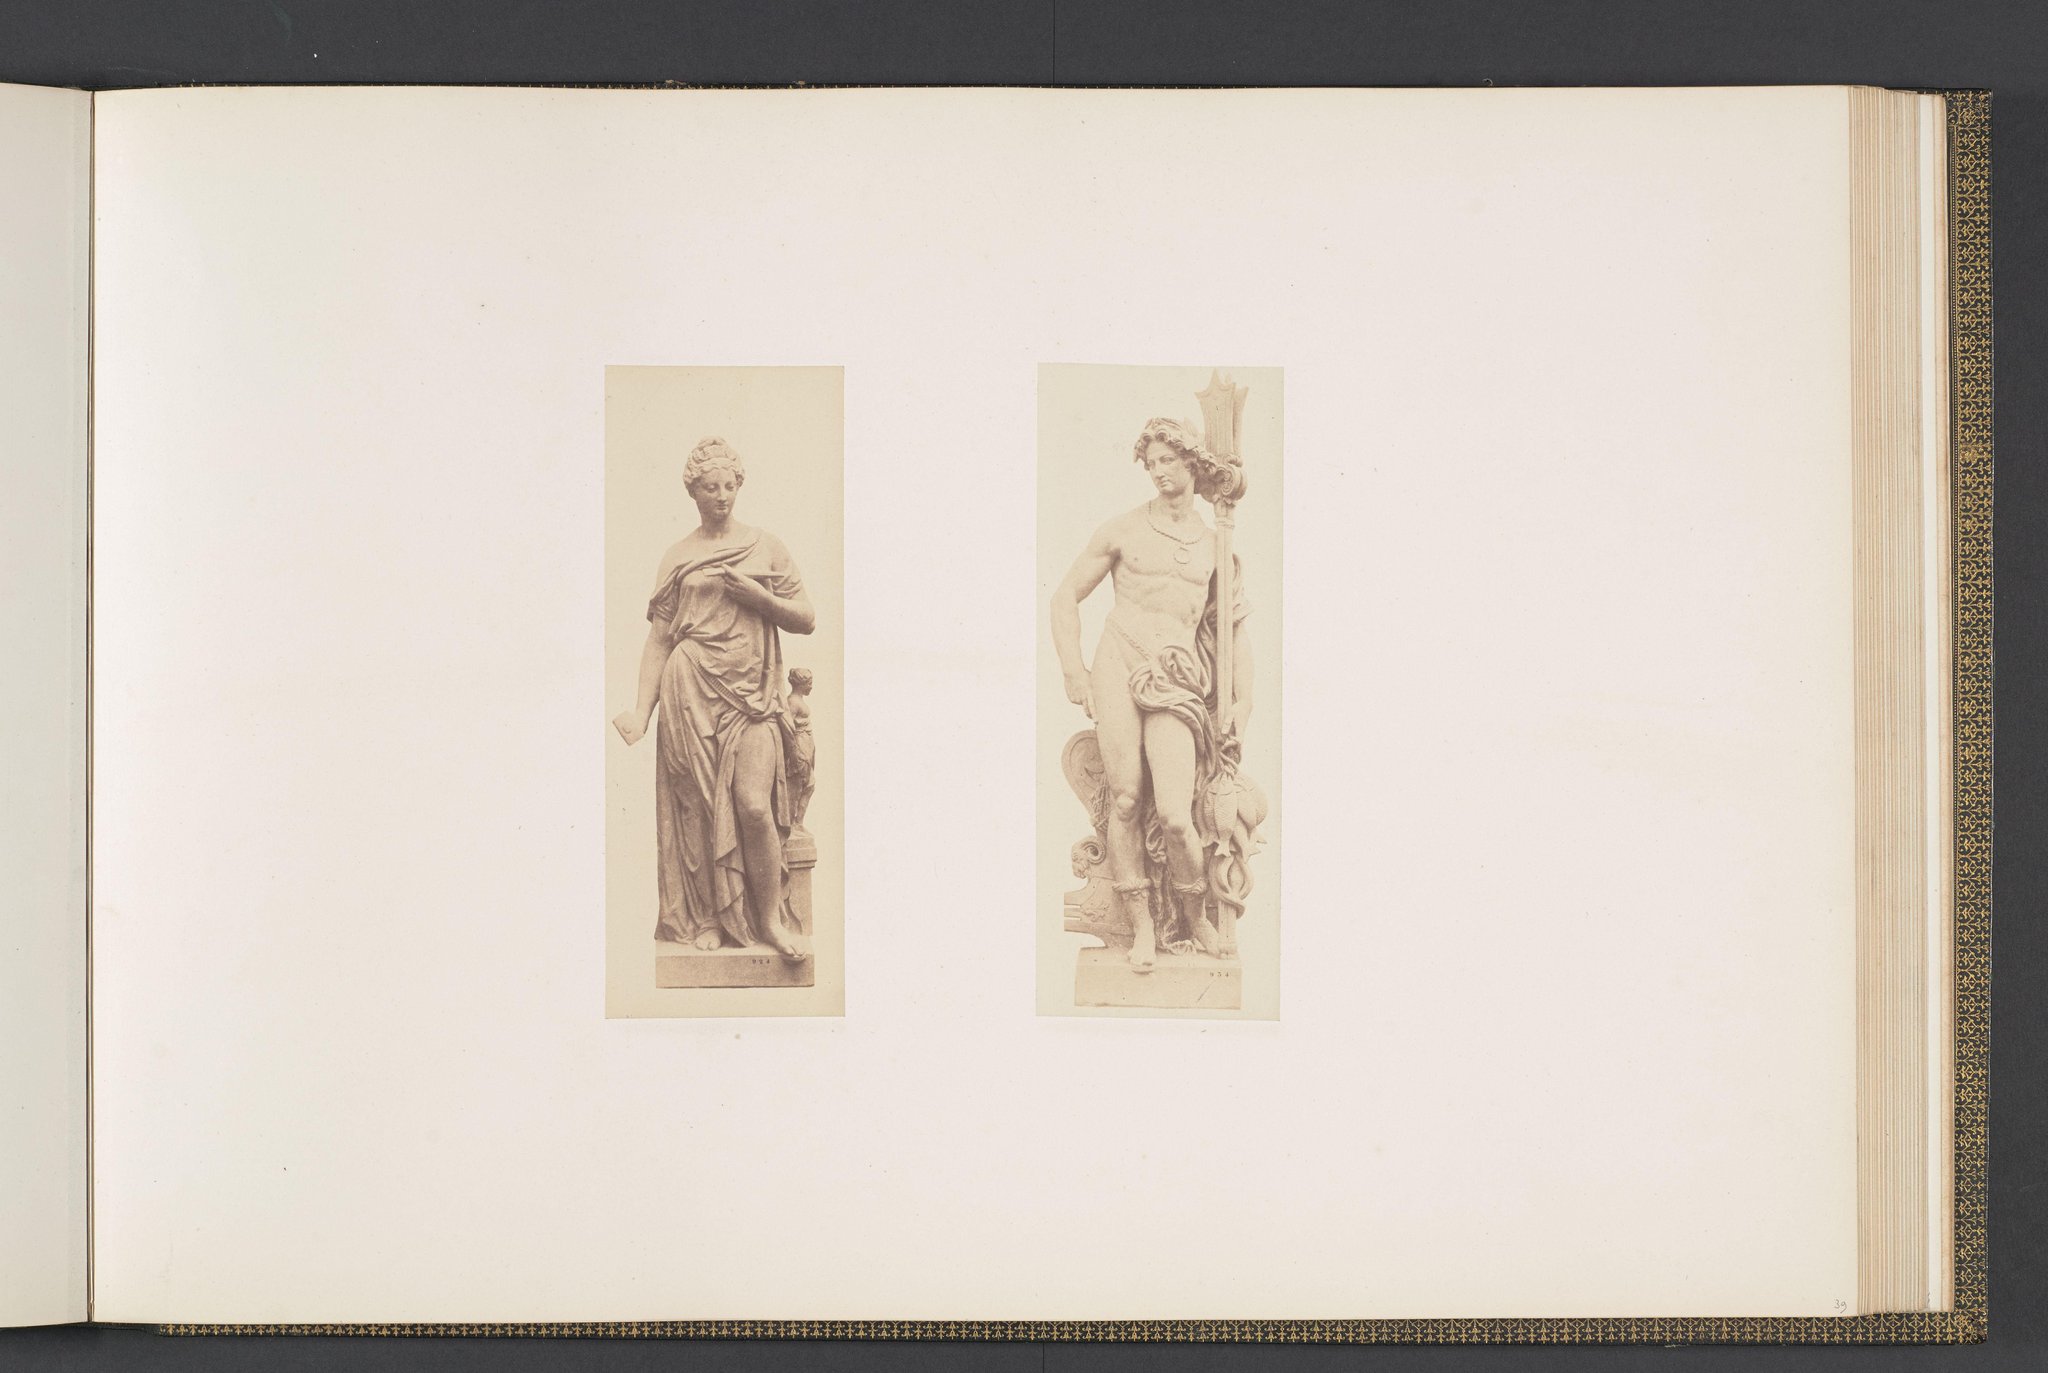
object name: album leaf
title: Gipsmodellen voor beeldhouwwerken op het Palais du Louvre: links "La Sculpture" door Jean Jules Allasseur en rechts "Le Pêcheur" door Charles Gumery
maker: édouard denis baldus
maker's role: fotograaf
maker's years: 1813-1889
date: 1855-1857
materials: paper, photographic support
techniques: salted paper print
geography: paris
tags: piece of sculpture, reproduction of a piece of sculpture, permanent exhibition, museum, paris, tuileries palace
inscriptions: number: ‘924 en 934’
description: Onderdeel van Réunion des Tuileries au Louvre 1852-1857, album 3.